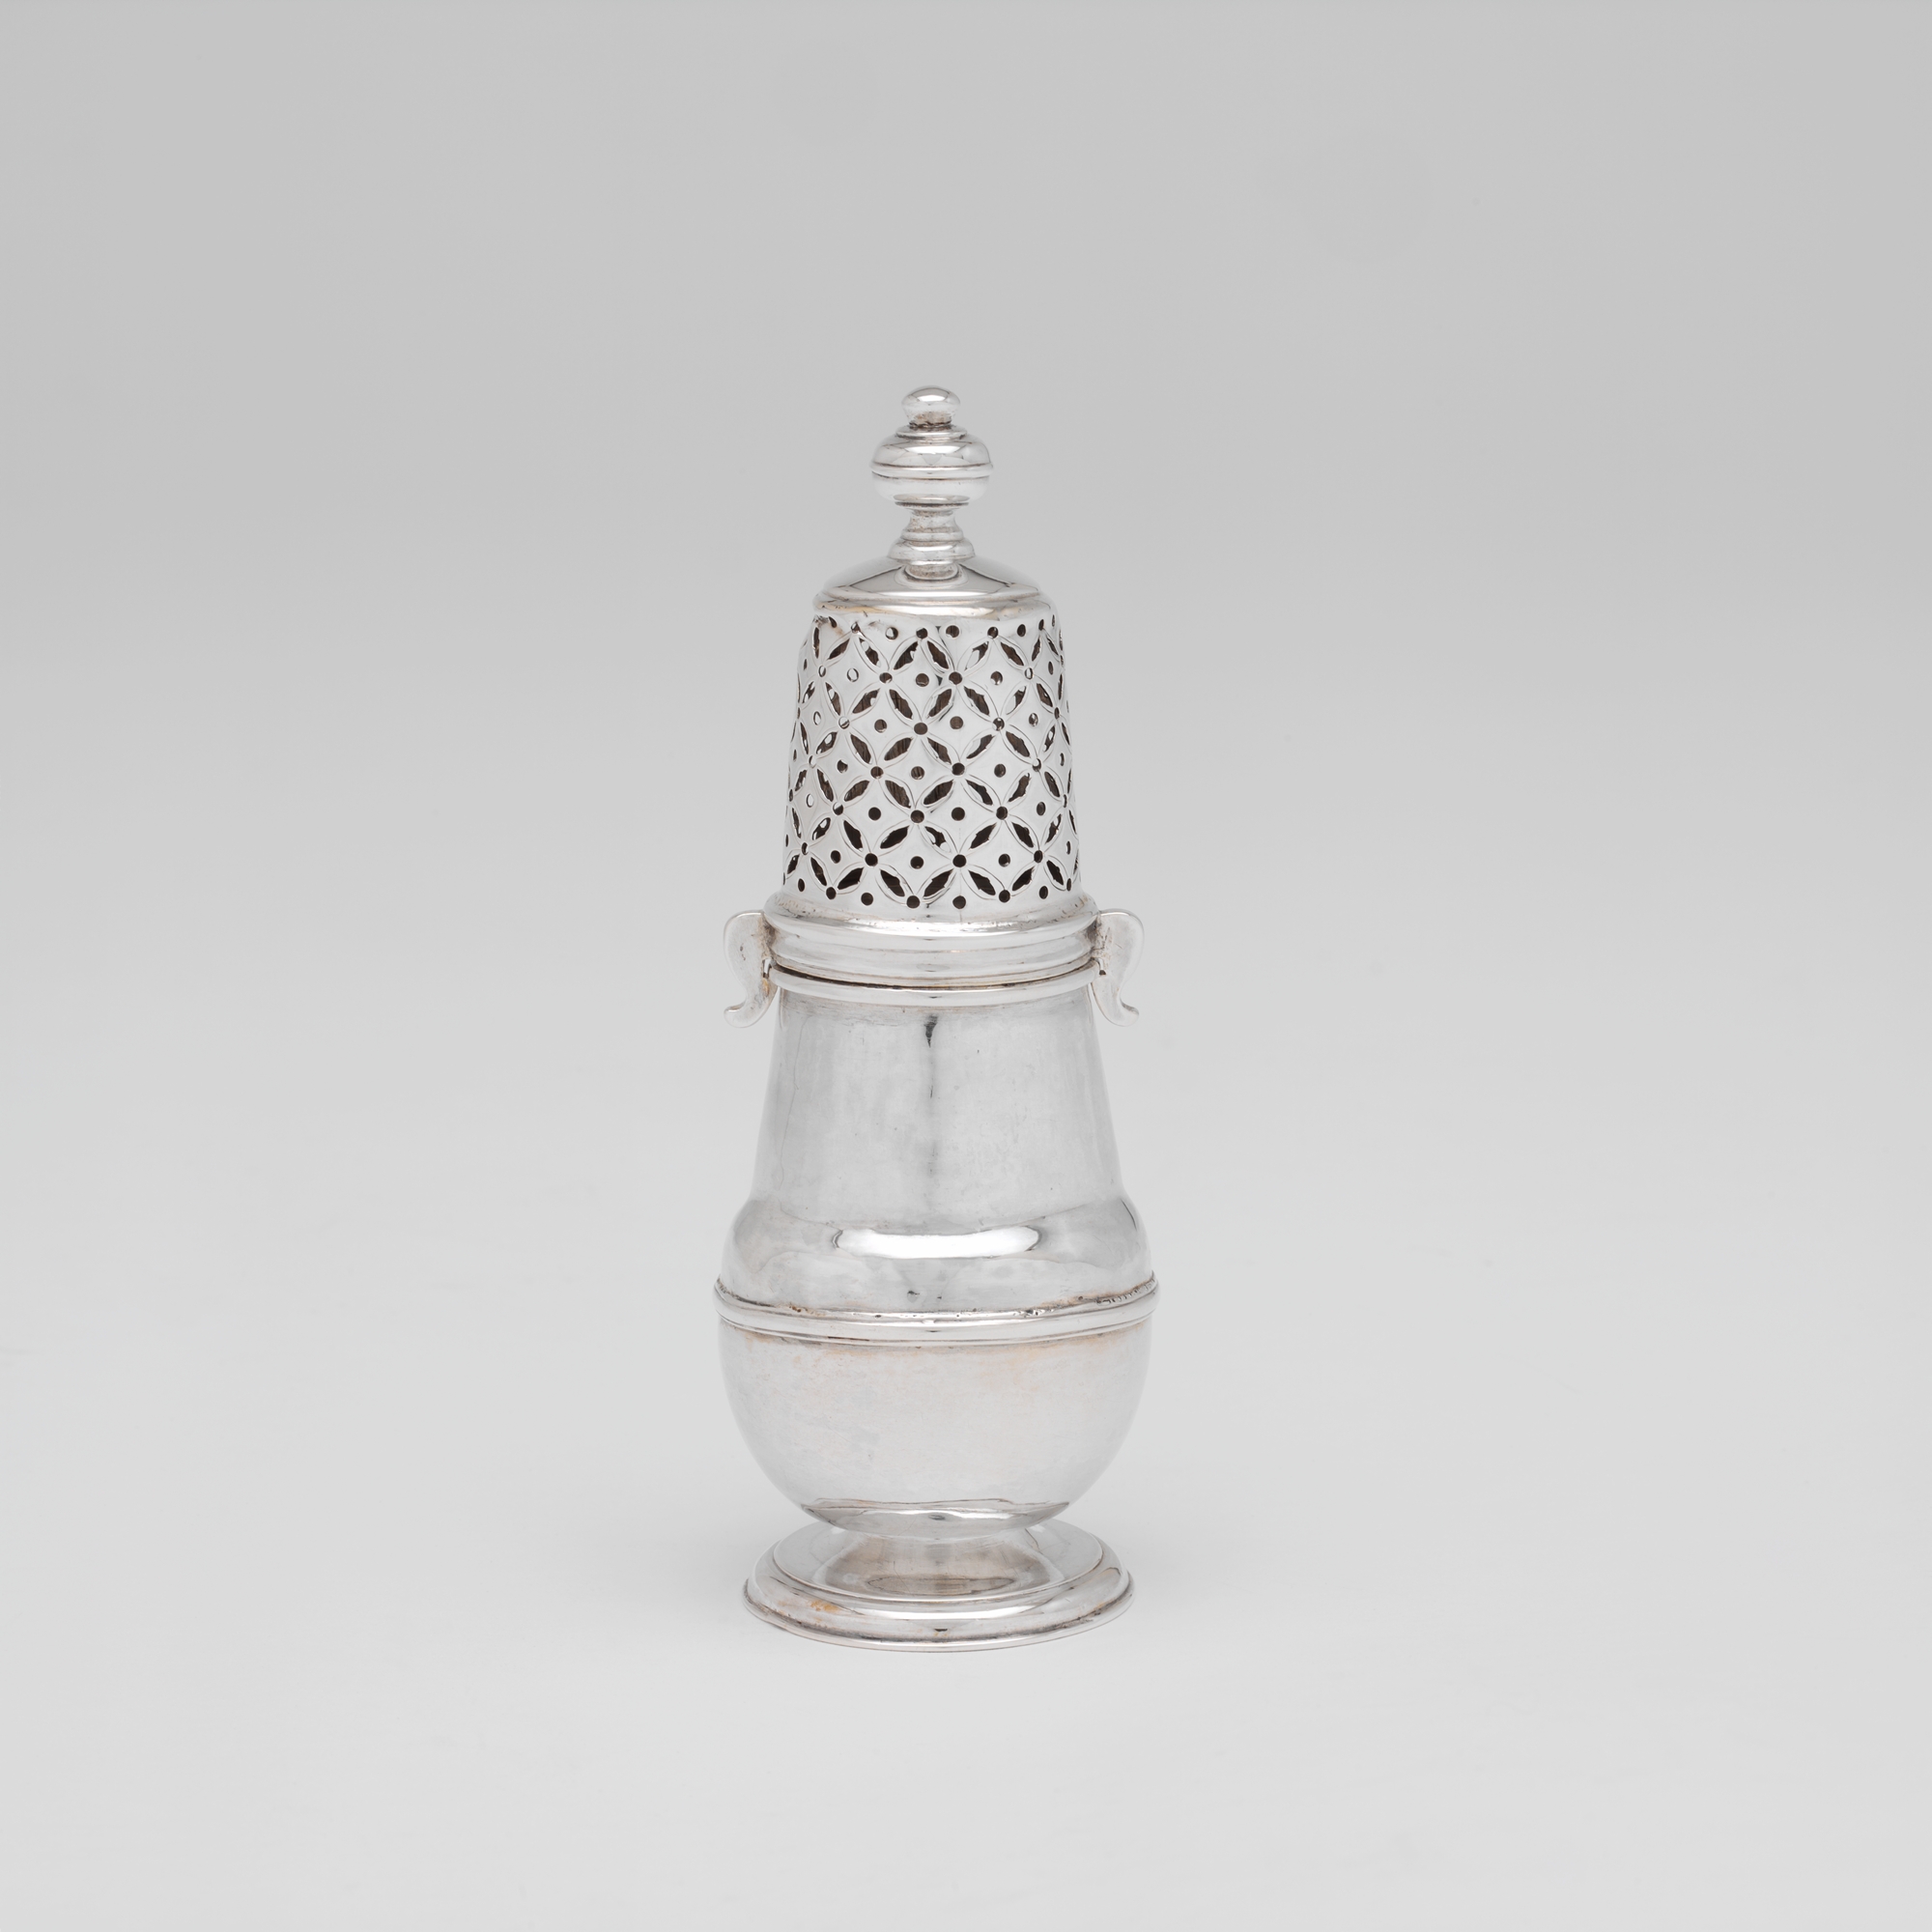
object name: caster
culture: american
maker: adrian bancker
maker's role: maker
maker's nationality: american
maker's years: 1703-1772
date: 1735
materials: silver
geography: united states